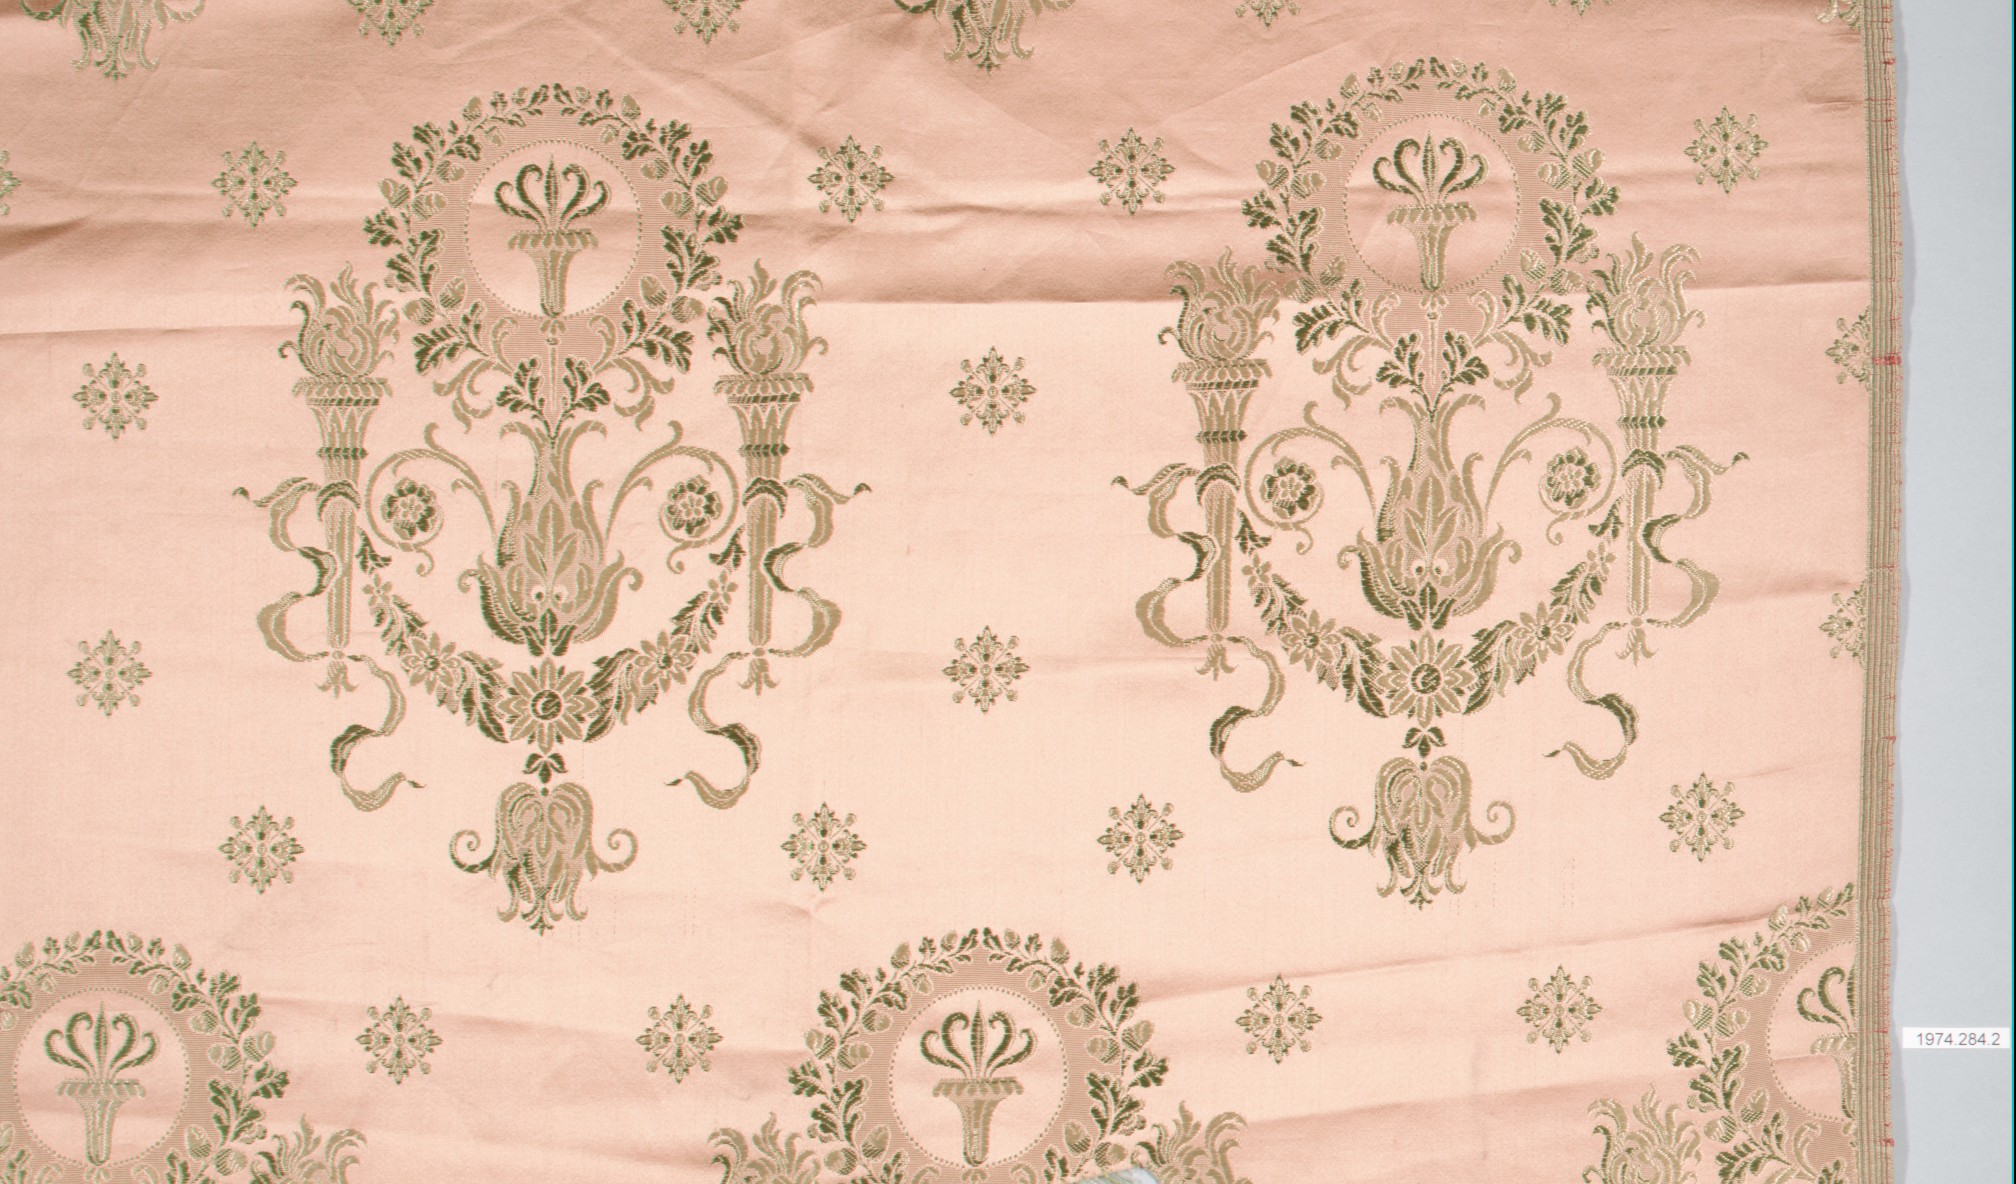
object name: piece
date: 1880-1889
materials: silk